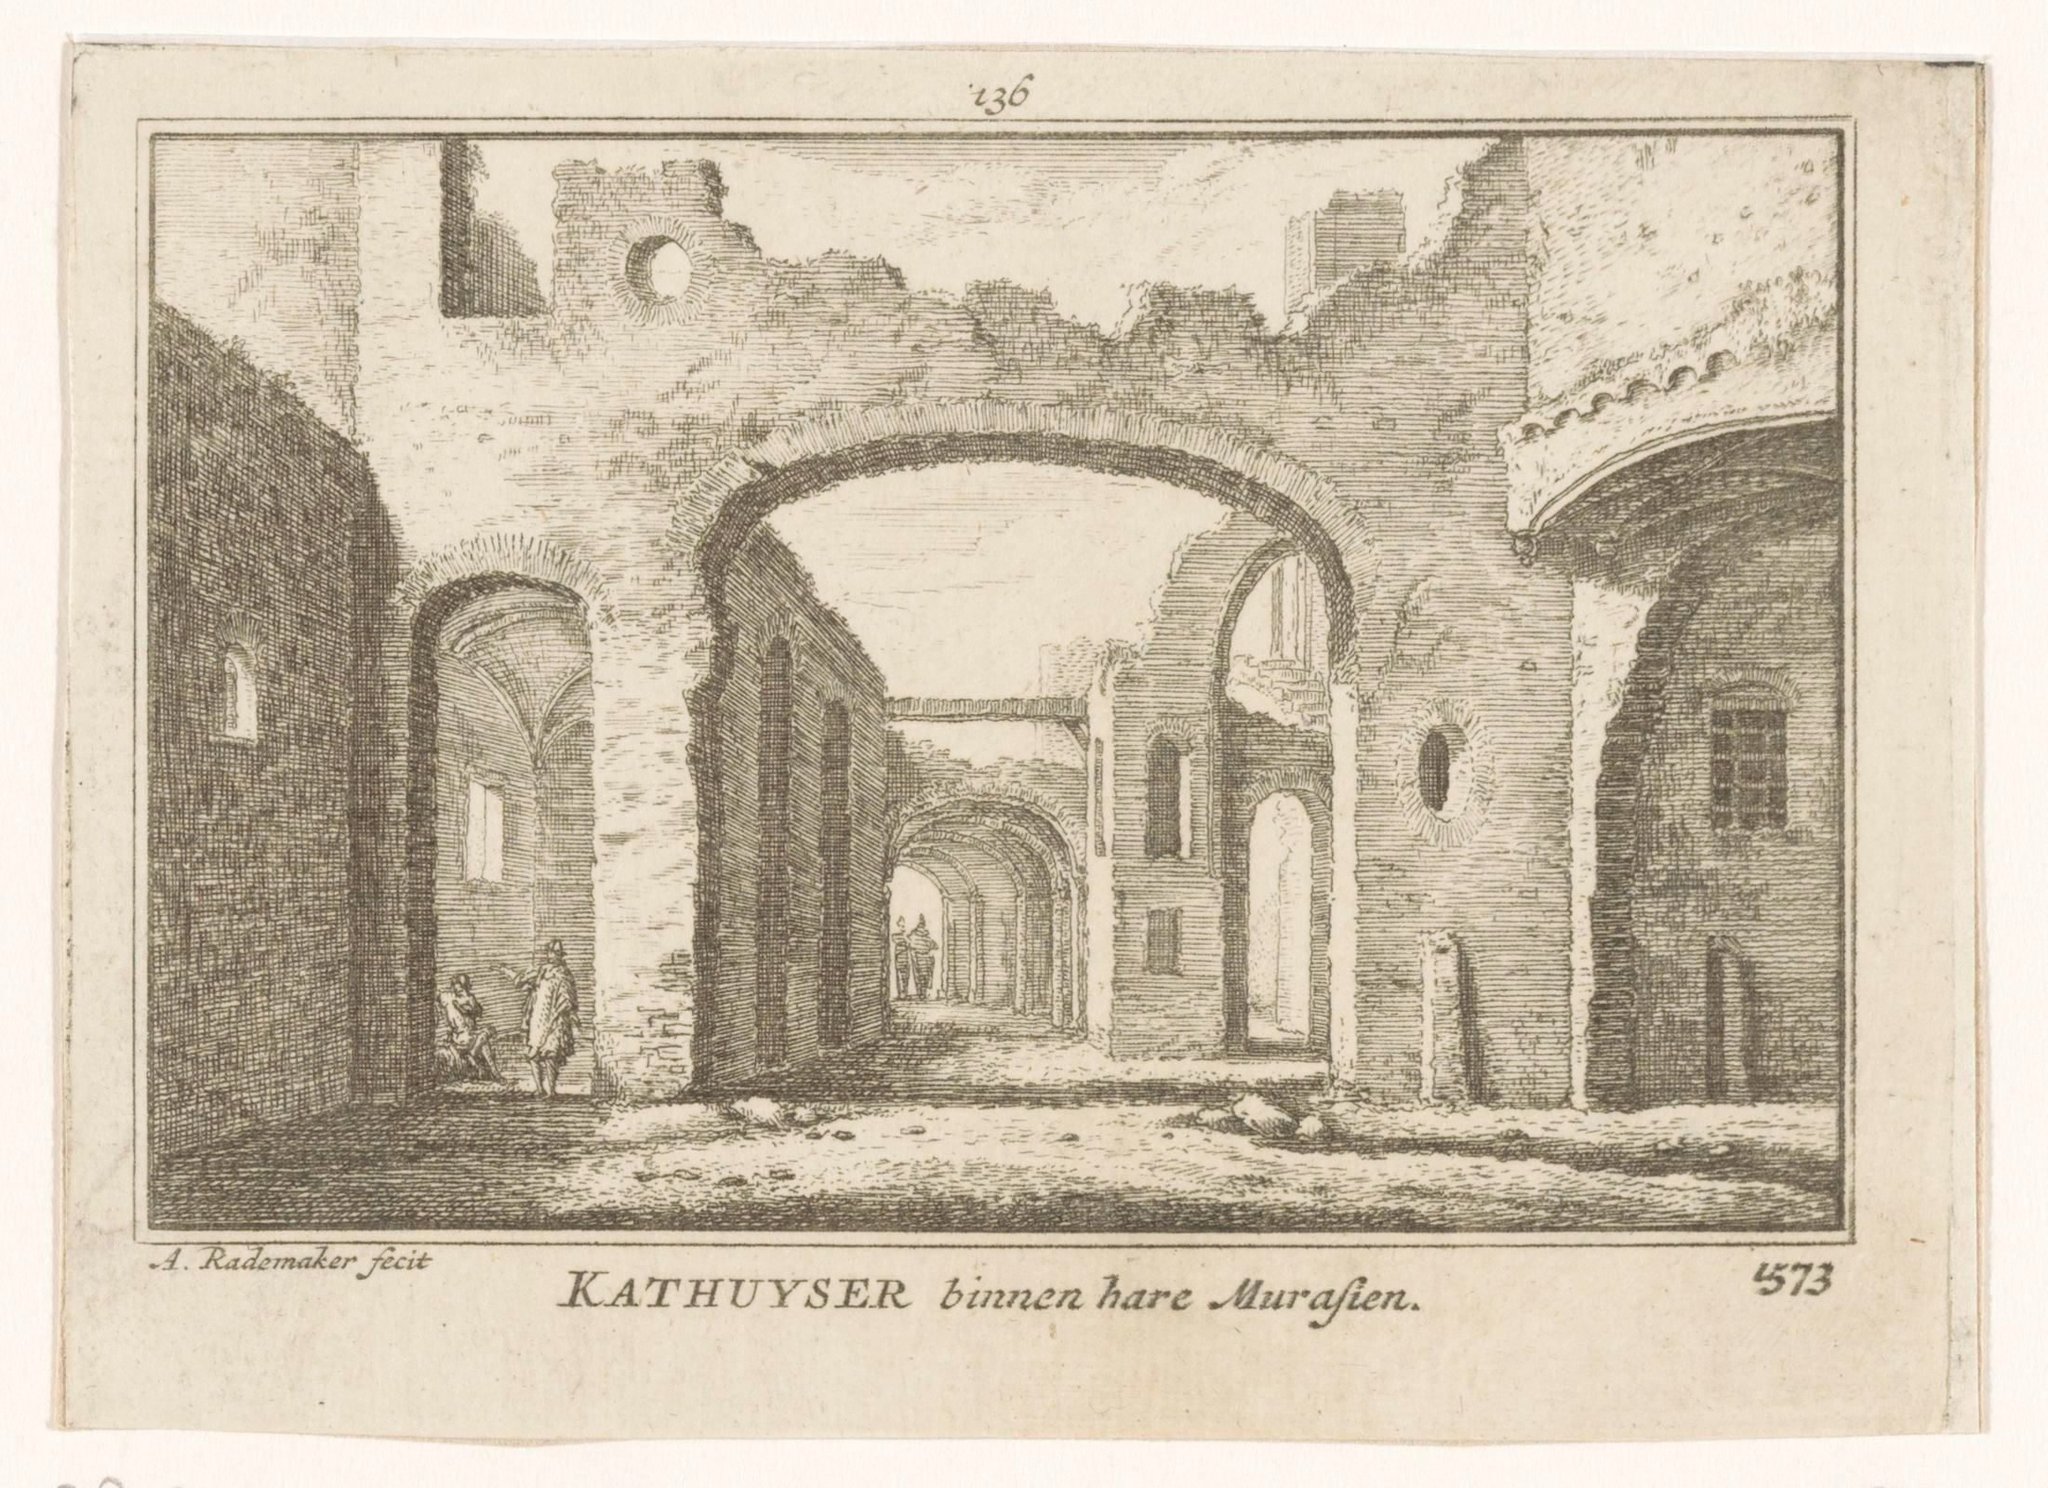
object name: book illustration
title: Kathuyser binnen hare murasien 1573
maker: abraham rademaker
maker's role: draughtsman, print maker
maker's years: 1676-1735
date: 1725-1803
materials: paper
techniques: engraving, etching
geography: amsterdam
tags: ruin of church, monastery, etc.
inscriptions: collector's mark: Lugt 2228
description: Prent ook gebruikt in: Rademaker, Abraham. Kabinet van Nederlandsche outheden en gezichten: vervat in 300 konstplaaten (…). 2 delen. Amsterdam: Willem Barents, 1725, dl. 1, ill. 136. Na 1725 is deze prent nog in verschillende heruitgaven verschenen, uitgegeven in 1727-1733, 1770-1771 en 1792-1803. Uit welke uitgave het huidige exemplaar precies komt is niet na te gaan.